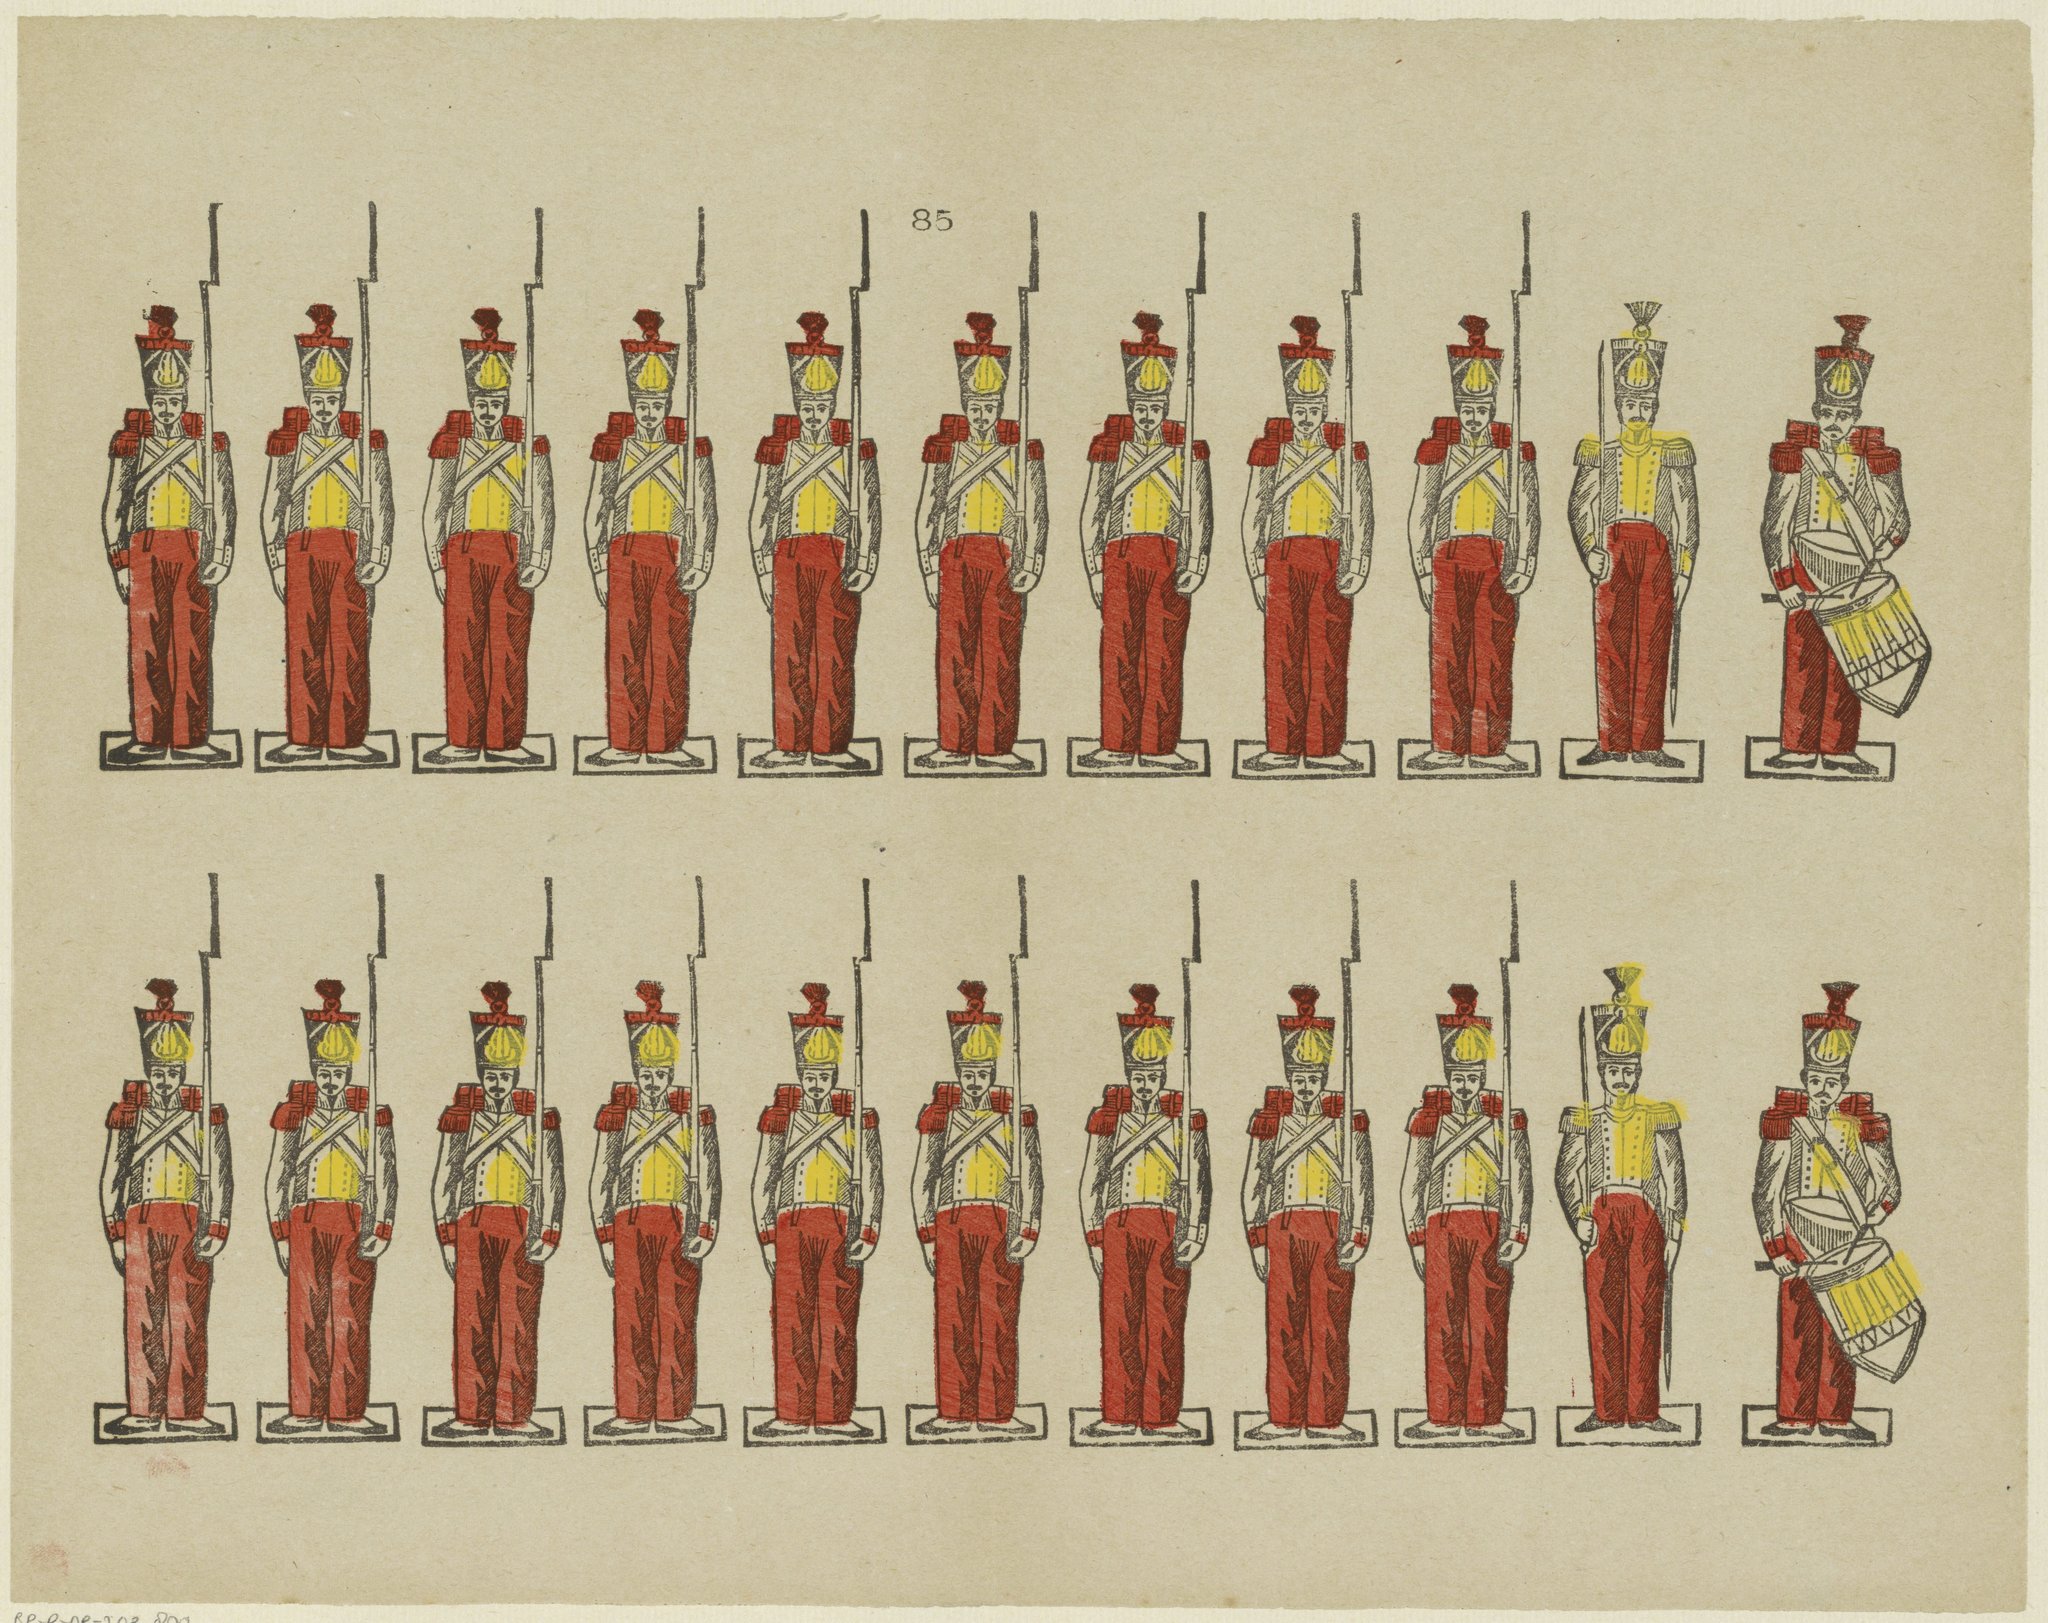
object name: print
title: Militairen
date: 1827-1894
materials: paper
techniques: colour, letterpress printing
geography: schaarbeek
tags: the soldier; the soldier's life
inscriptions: collector's mark: Lugt 2760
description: Blad met 22 voorstellingen van militairen. Genummerd midden boven: 85.